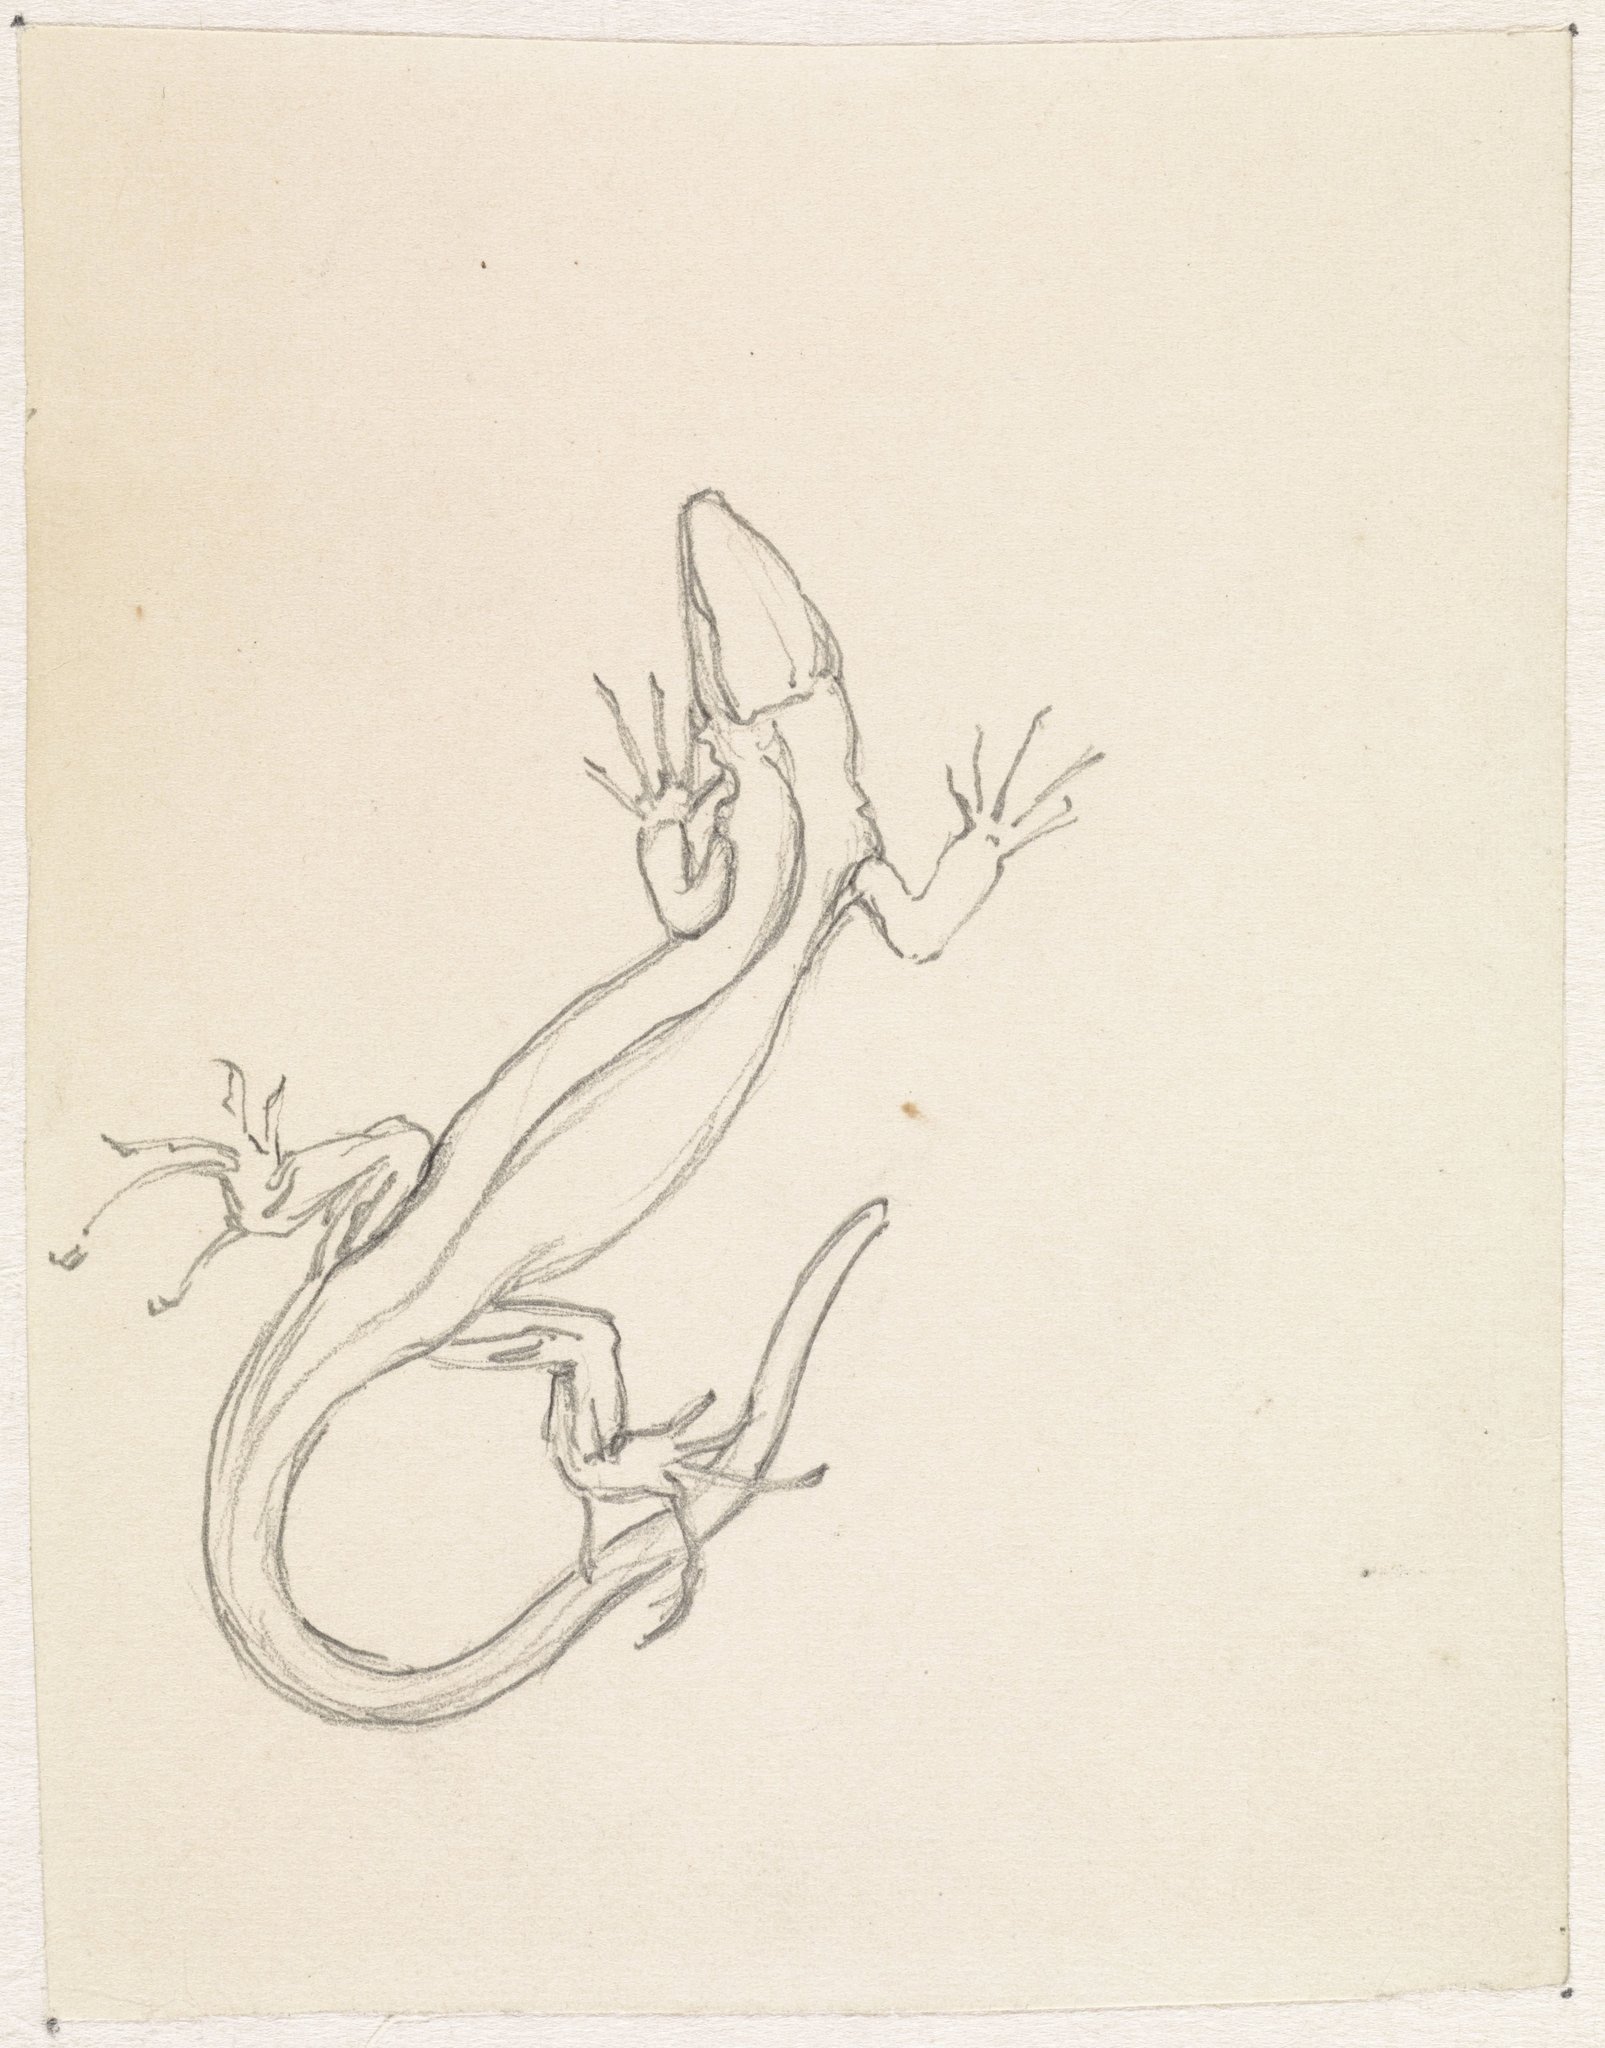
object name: drawing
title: Hagedis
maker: julie de graag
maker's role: draughtsman, print maker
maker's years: 1877-1924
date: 1887-1924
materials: paper, pencil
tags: lizards